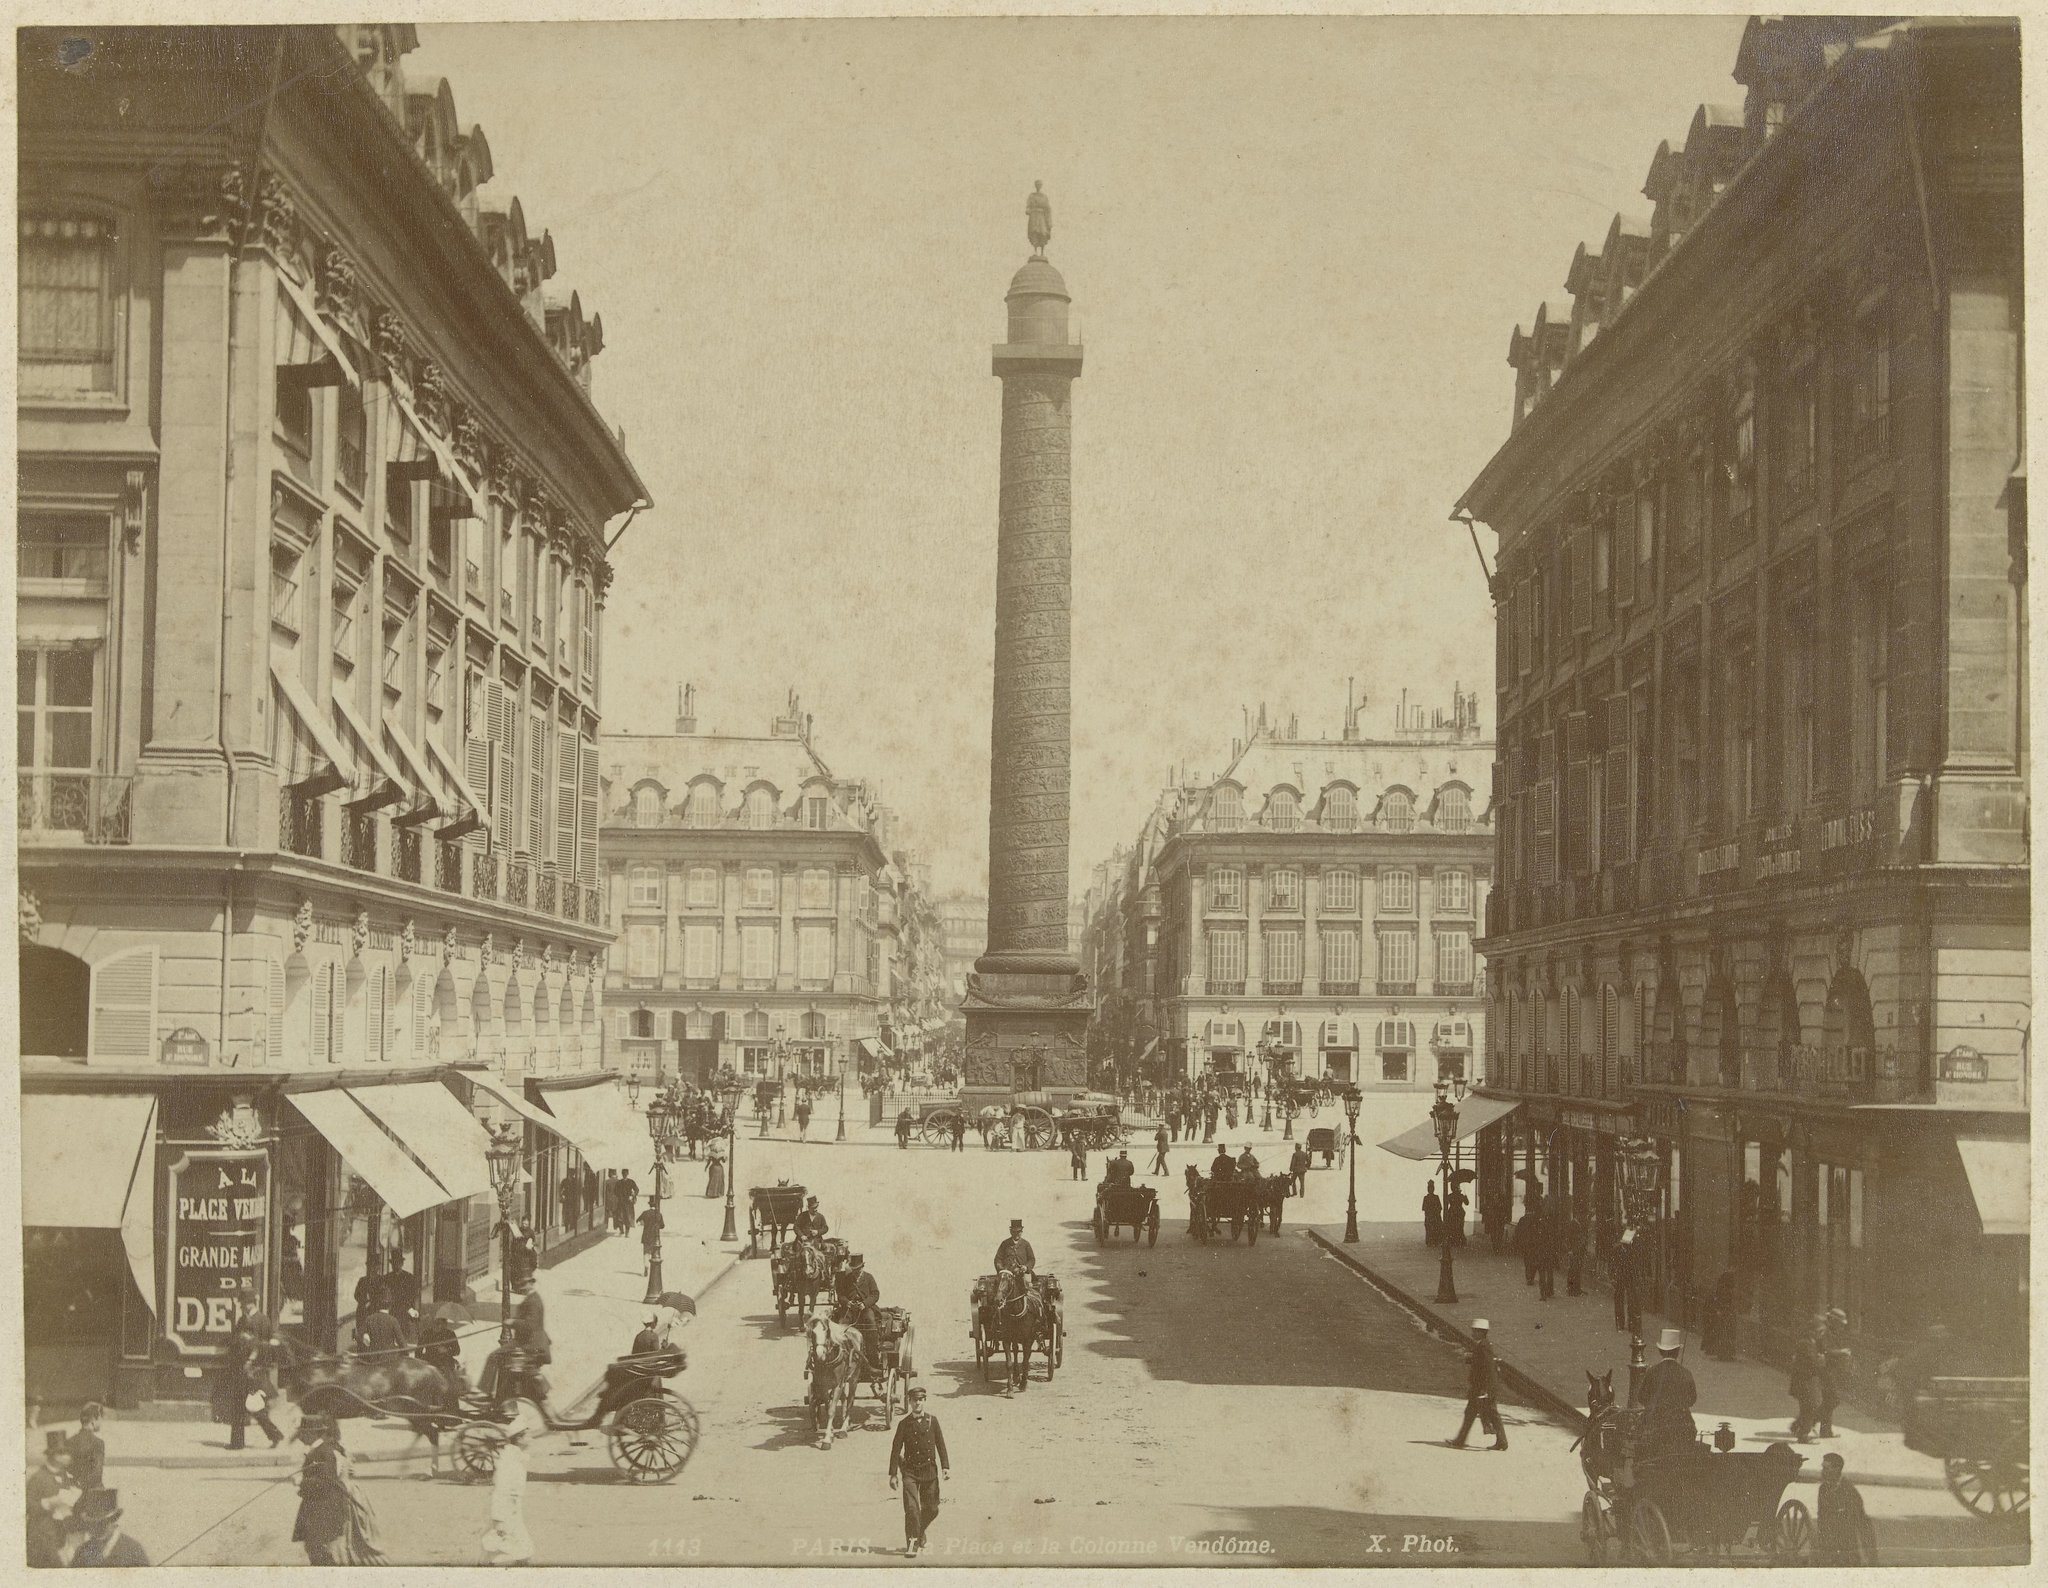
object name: photograph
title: Paris. - La Place et la Colonne Vendôme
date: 1887-1900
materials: cardboard, paper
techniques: albumen print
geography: paris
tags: square, place, circus, etc., triumphal column with helical friezes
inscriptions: inscription: ‘1113 Paris. - La Place et la Colonne Vendôme. X. Phot.’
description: Tussen 1887 en ca. 1900 werkten Neurdein frères onder andere onder de naam 'X phot.'.